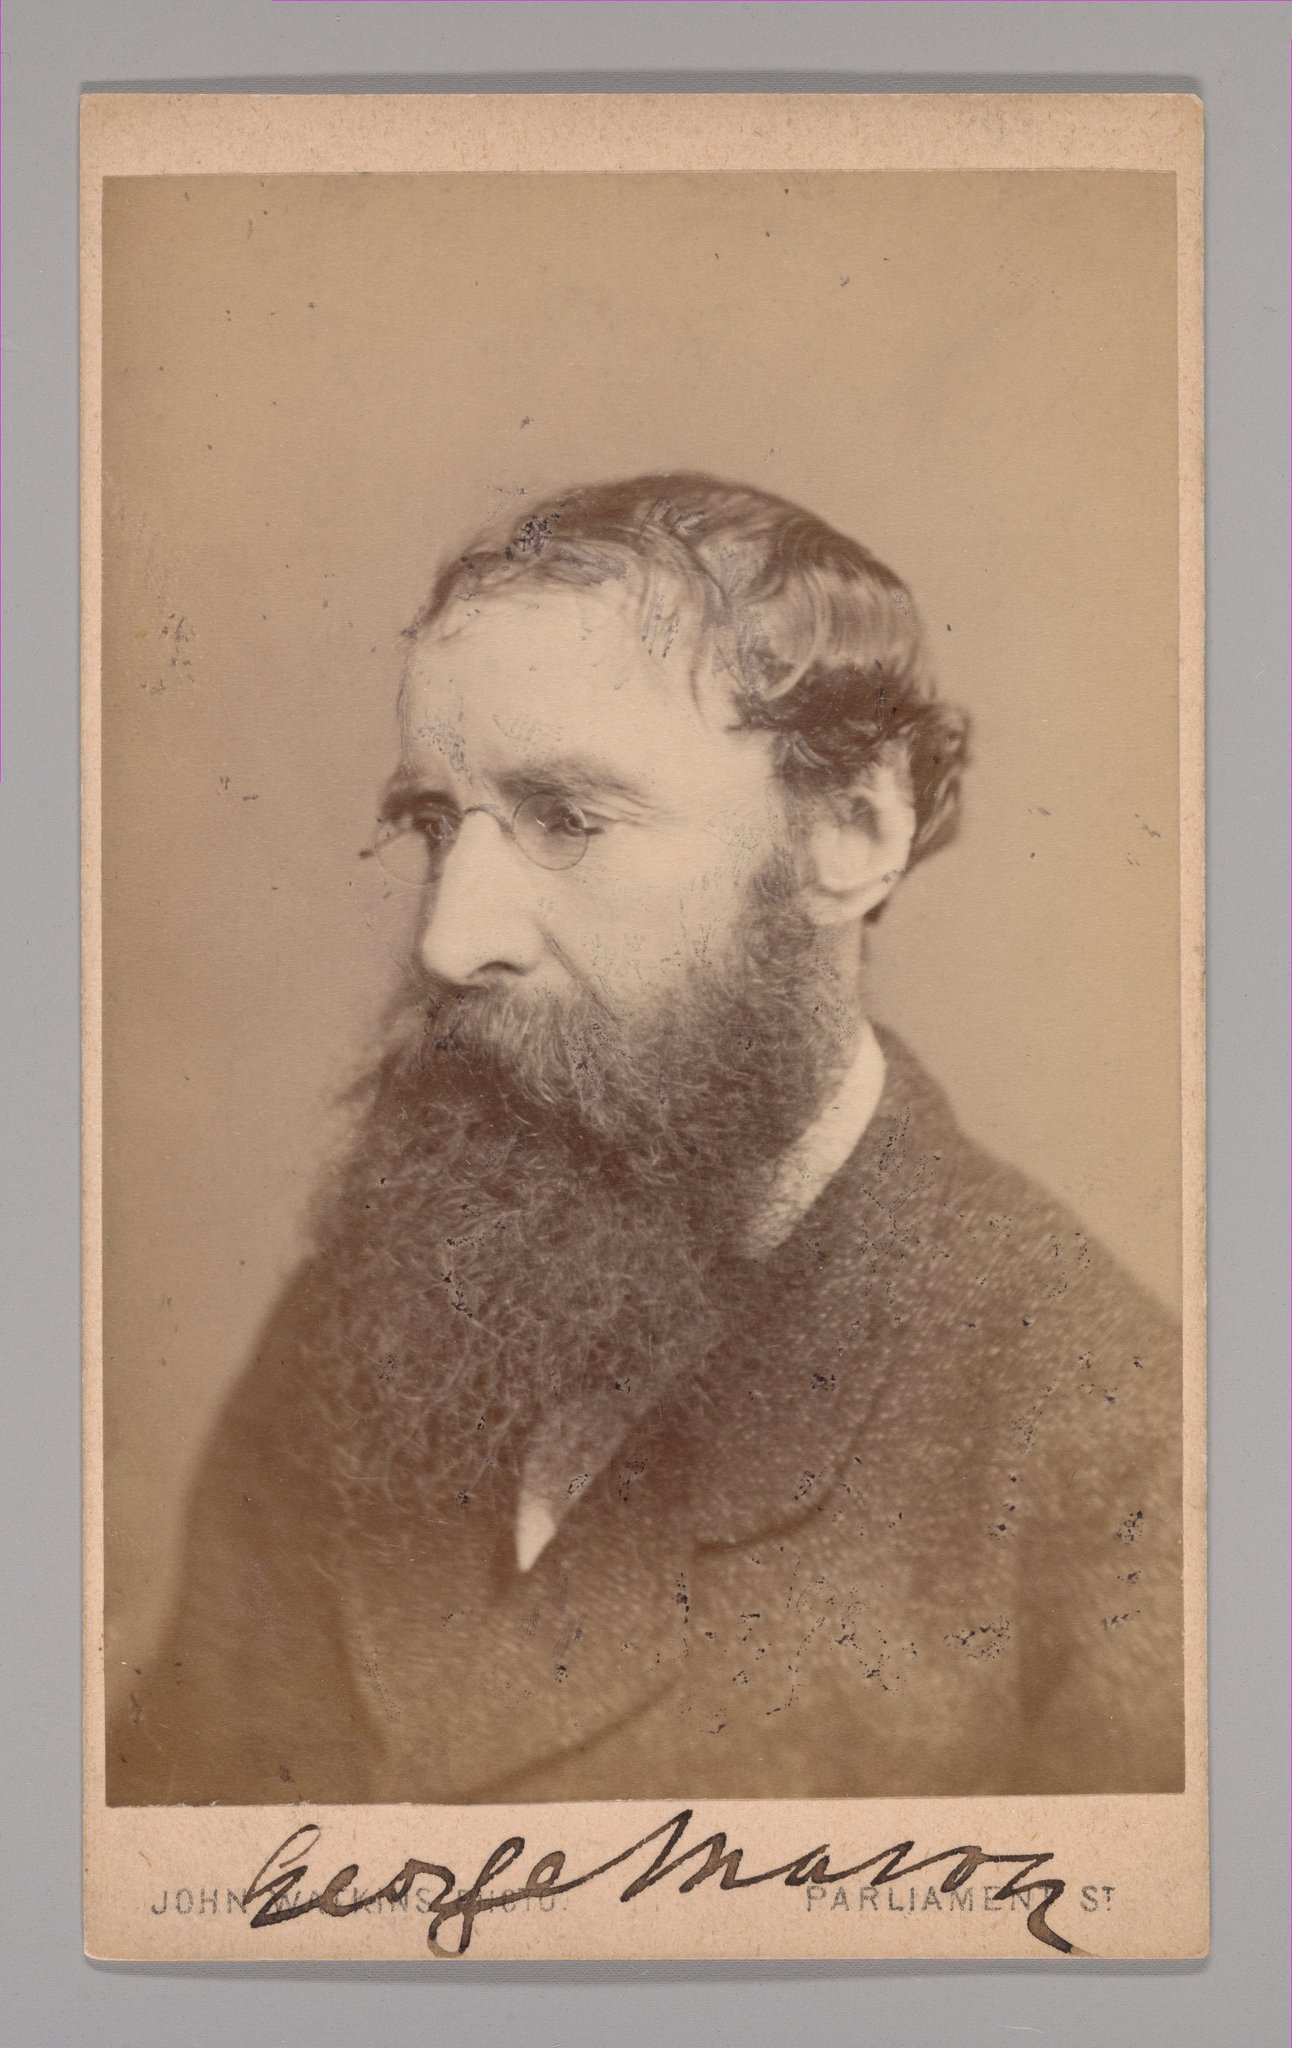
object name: carte de visite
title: [George Mason]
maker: john and charles watkins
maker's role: photography studio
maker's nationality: british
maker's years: 1840-1875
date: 1860-1869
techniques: albumen silver print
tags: men,portraits,profiles